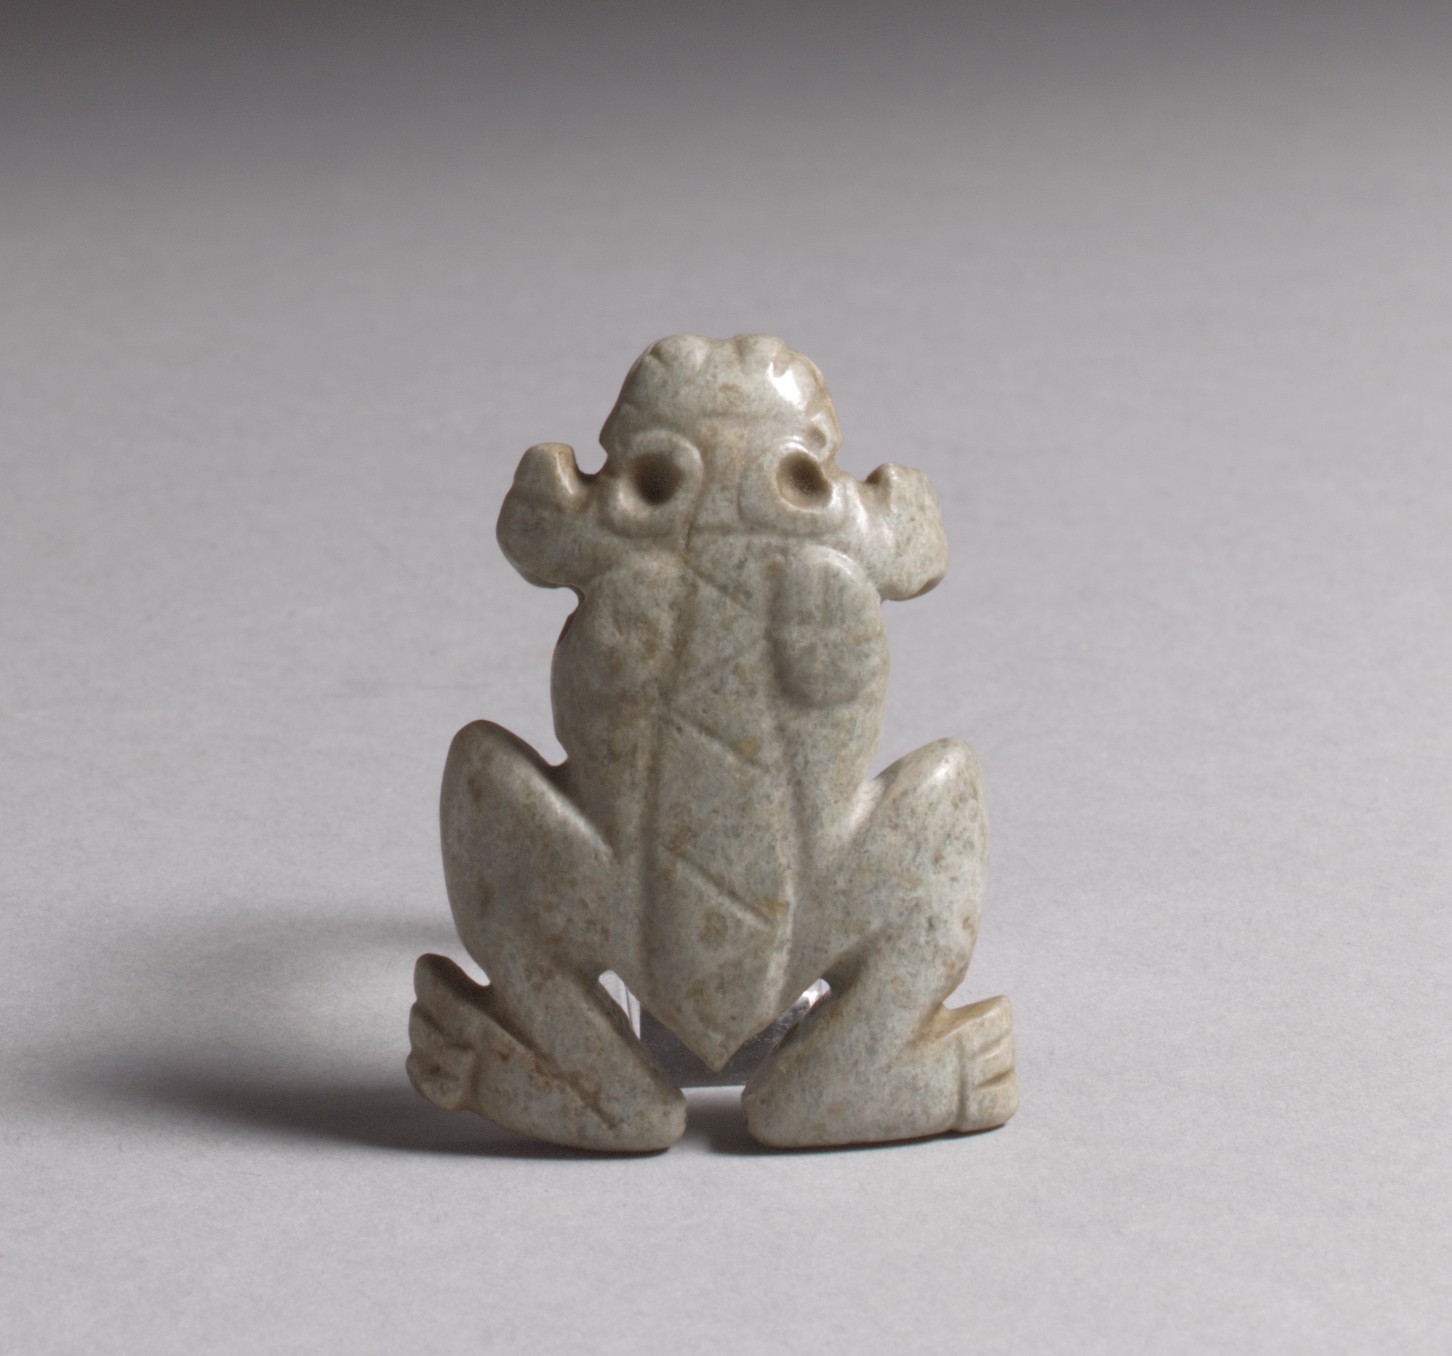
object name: pendant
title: Frog pendant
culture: atlantic watershed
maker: central region artist(s)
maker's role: artist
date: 300-800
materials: jade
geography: costa rica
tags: frogs